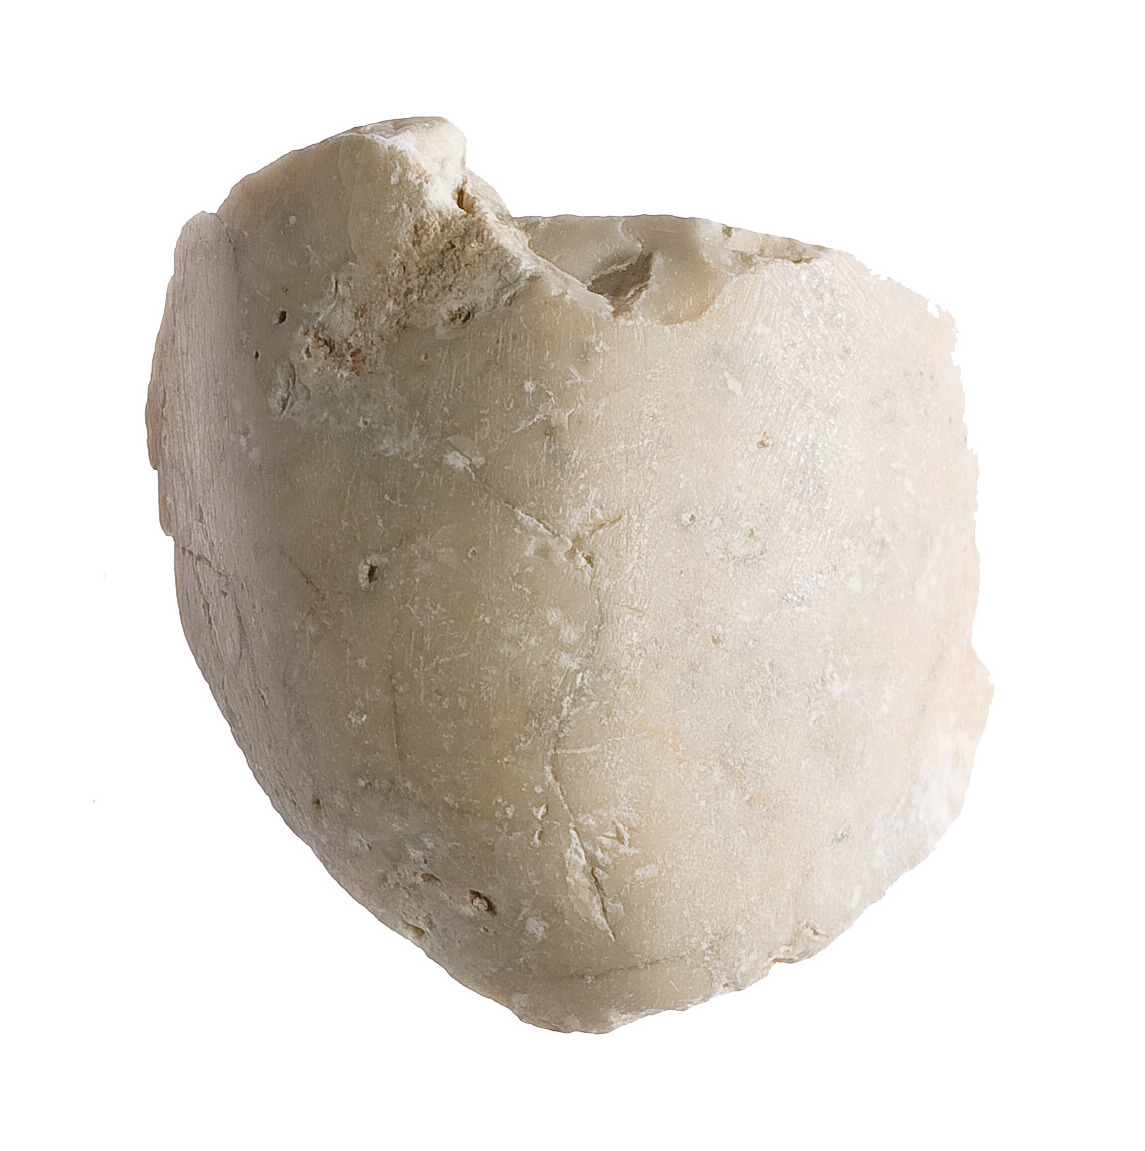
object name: elbow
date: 1353-1336 BCE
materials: limestone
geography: egypt